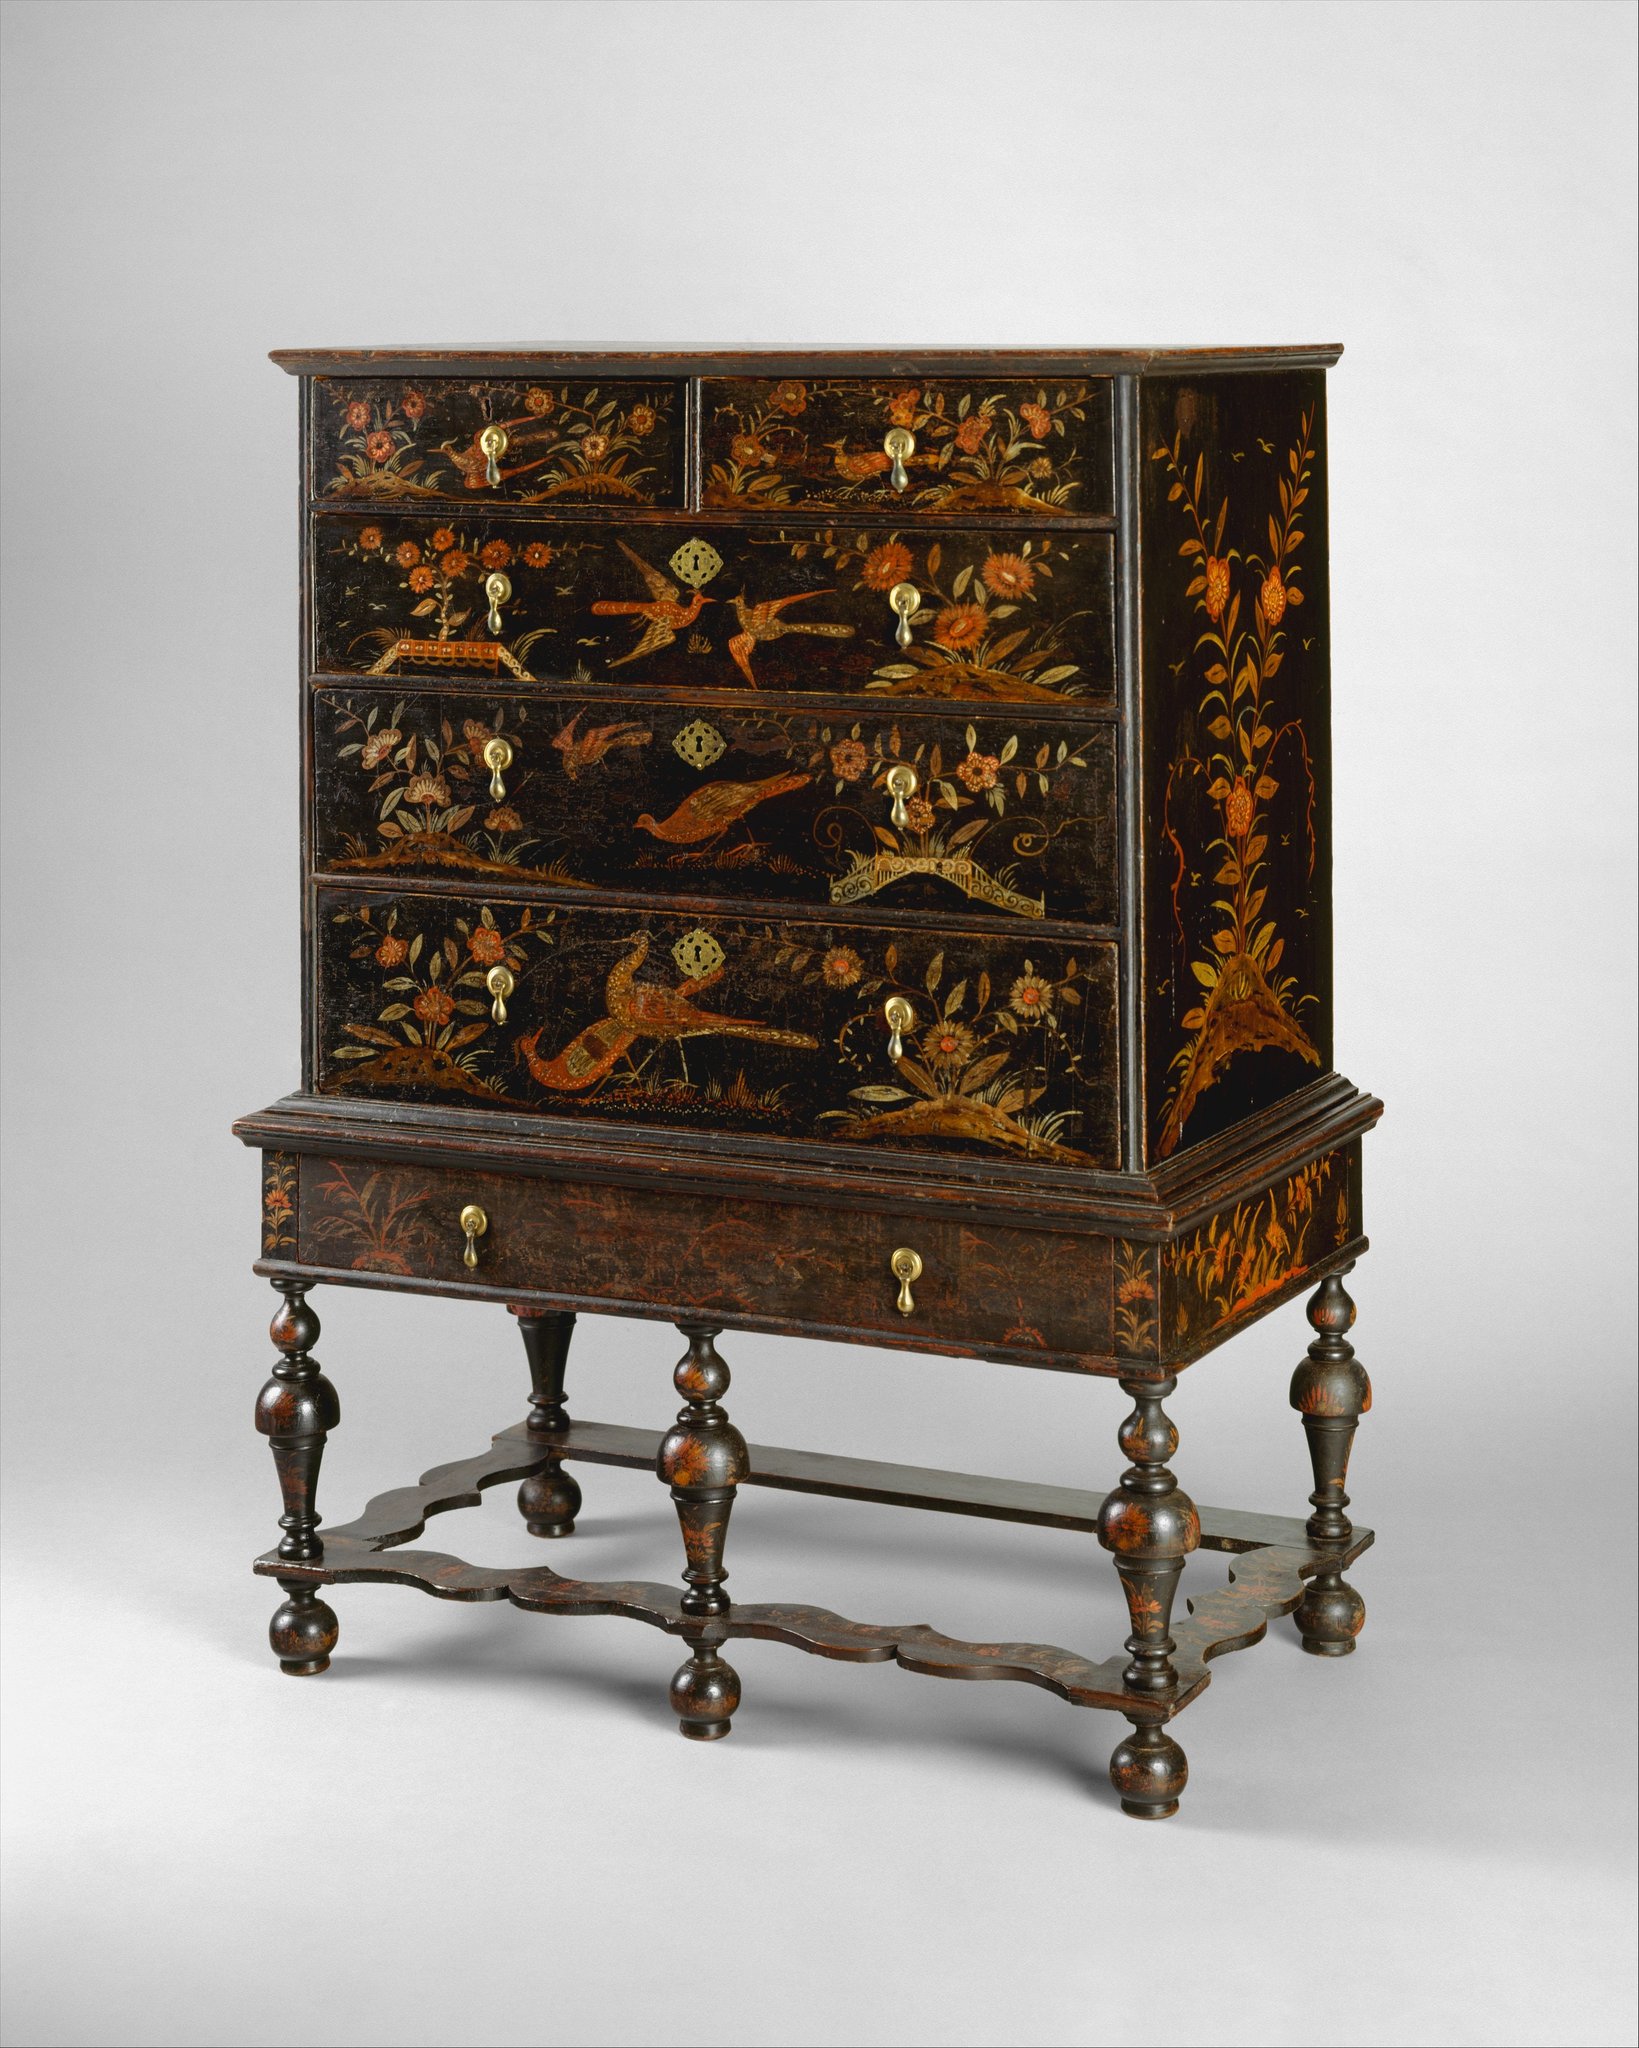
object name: chest of drawer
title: High chest of drawers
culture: american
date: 1710-1725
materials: wood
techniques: painting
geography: united states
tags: birds,flowers